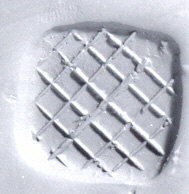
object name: stamp seal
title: Loop (?) handled rectangular stamping device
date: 6000-5668 BCE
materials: mineral, stone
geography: northern syria (?)